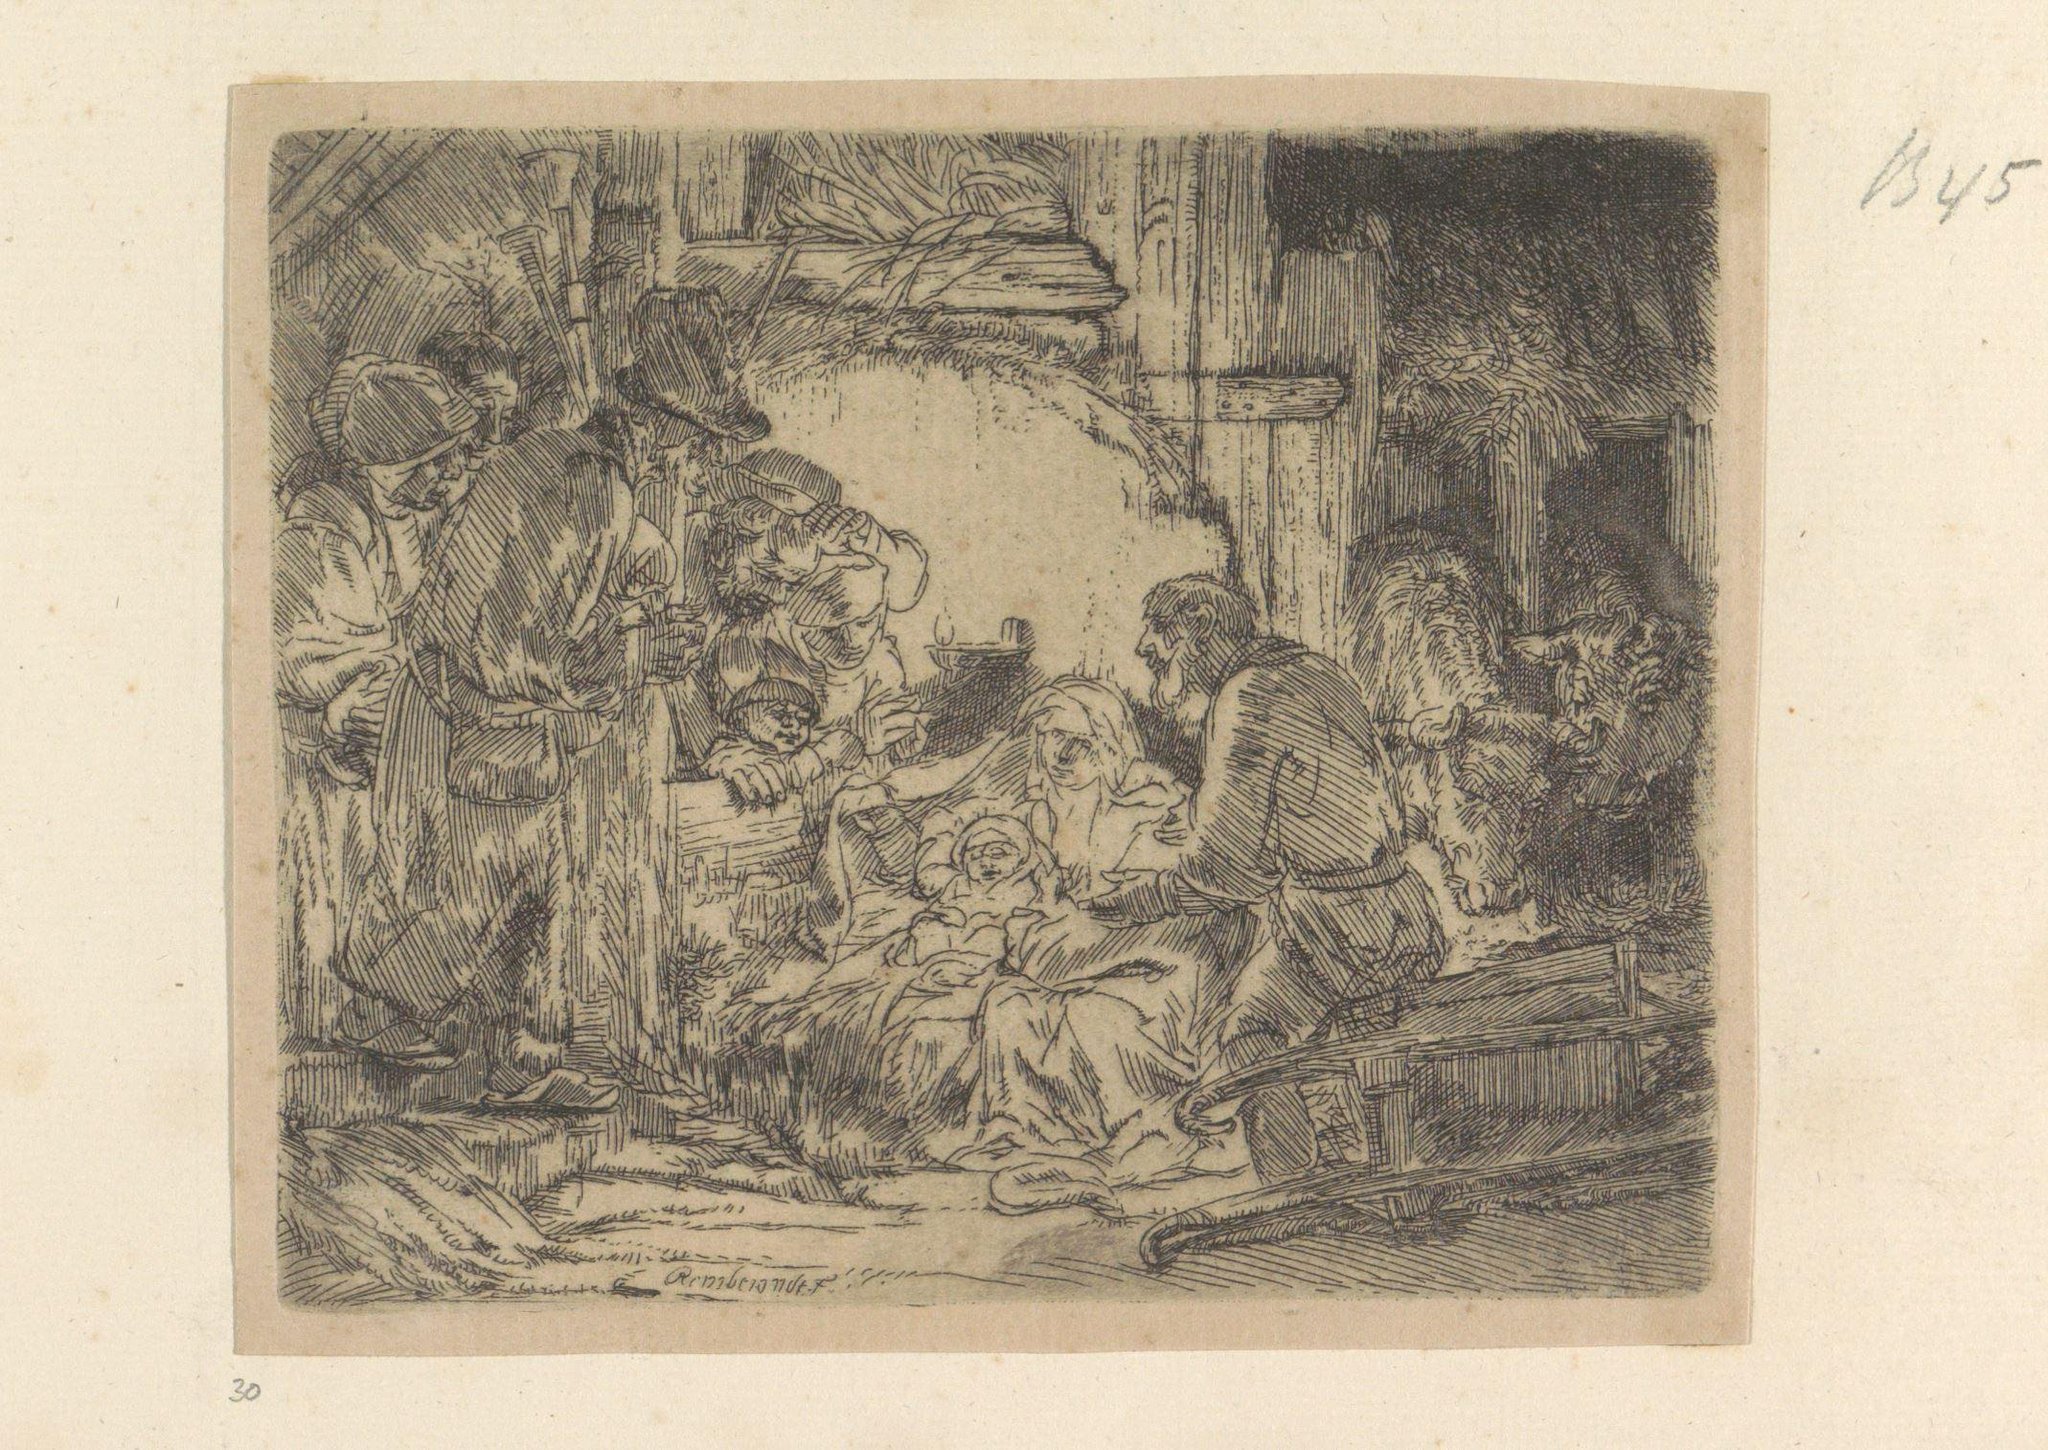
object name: print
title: Aanbidding der herders: met de olielamp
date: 1652-1656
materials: paper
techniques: etching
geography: paris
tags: adoration of the christ-child by the shepherds; mary and joseph present